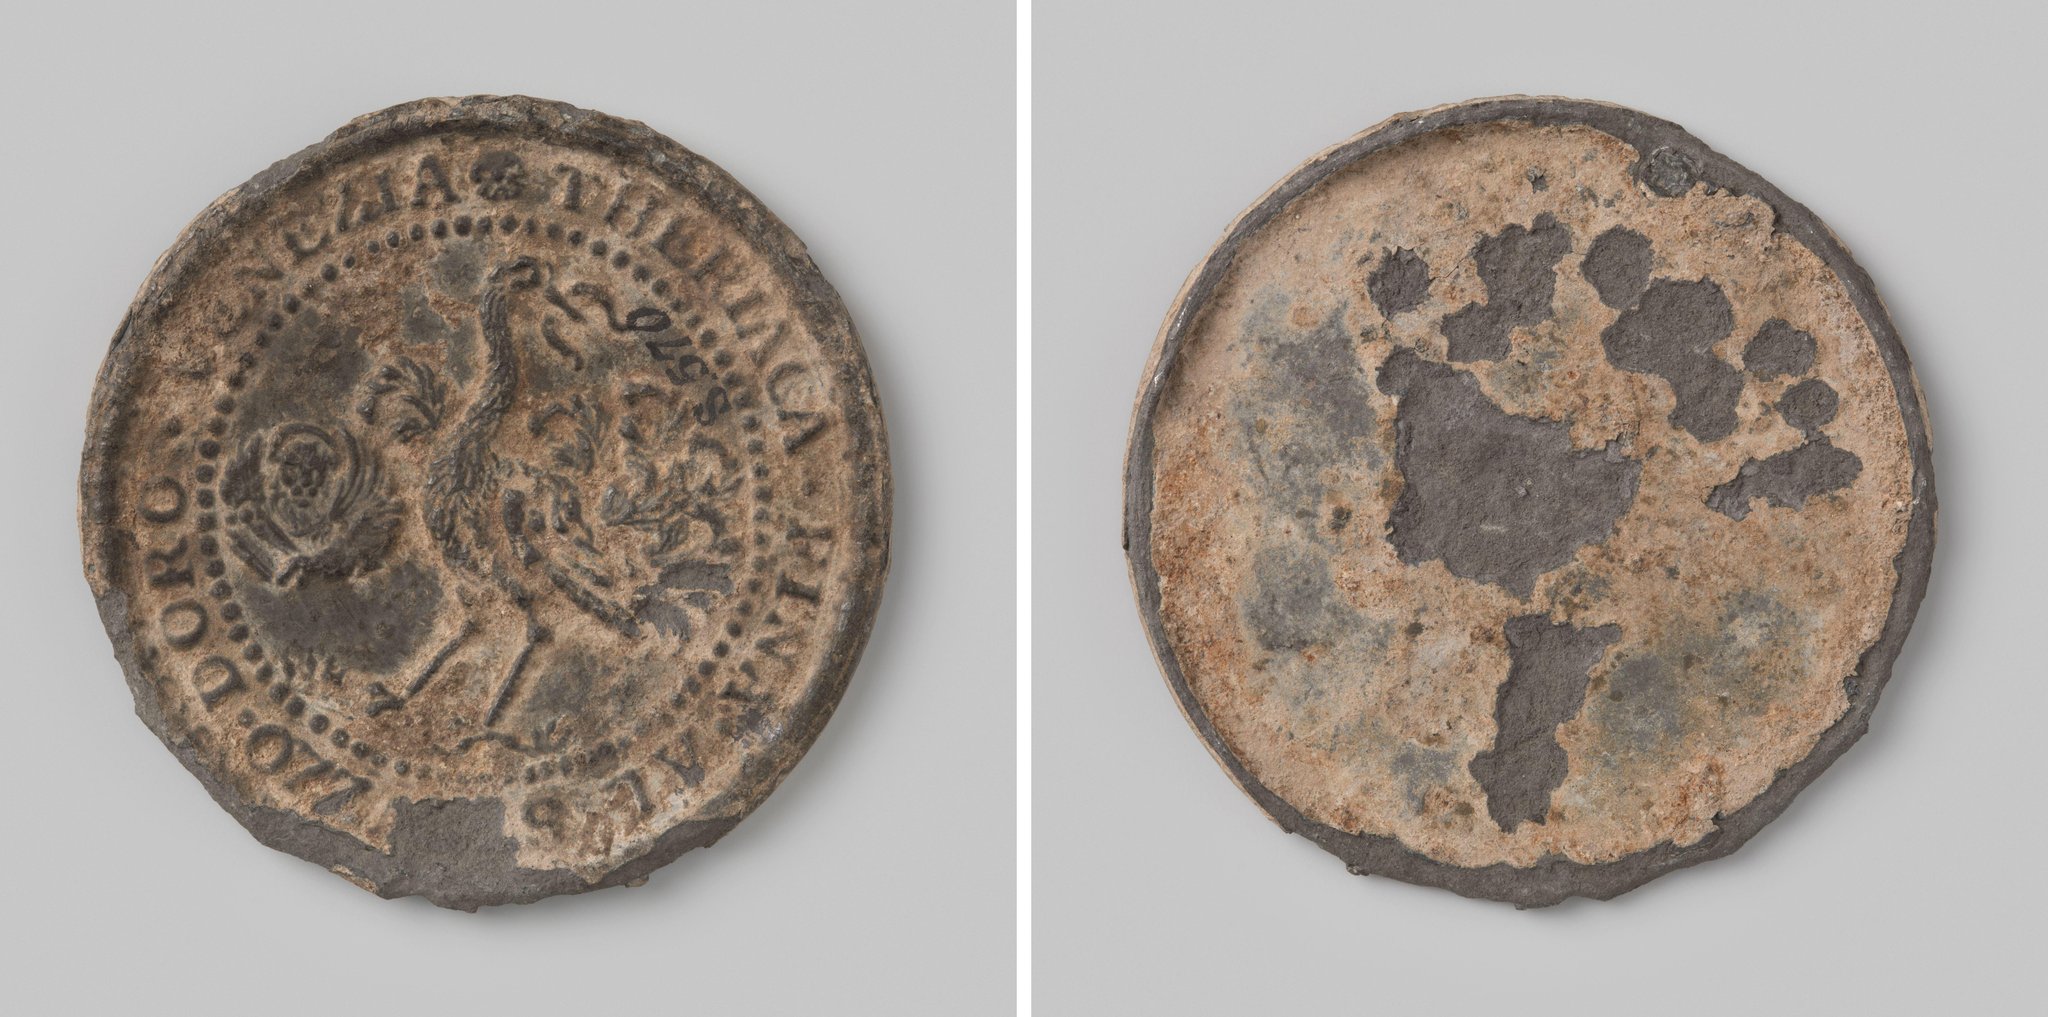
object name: lid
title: Deksel voor een pot Venetiaanse triaca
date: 1600-1700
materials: lead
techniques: pressing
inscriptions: circumscription: ‘THERIACA FINA AL STRUZZO D ORO VENEZIA’, inscription: ‘S. 576’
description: Loden deksel, de randen grotendeels verdwenen, aan de bovenkant een afbeelding in relief van een omziende struisvogel naar links met slang in de bek en links de leeuw van Sint Marcus, binnen een parelcirkel waarom een omschrift. Aangezien voor penning.